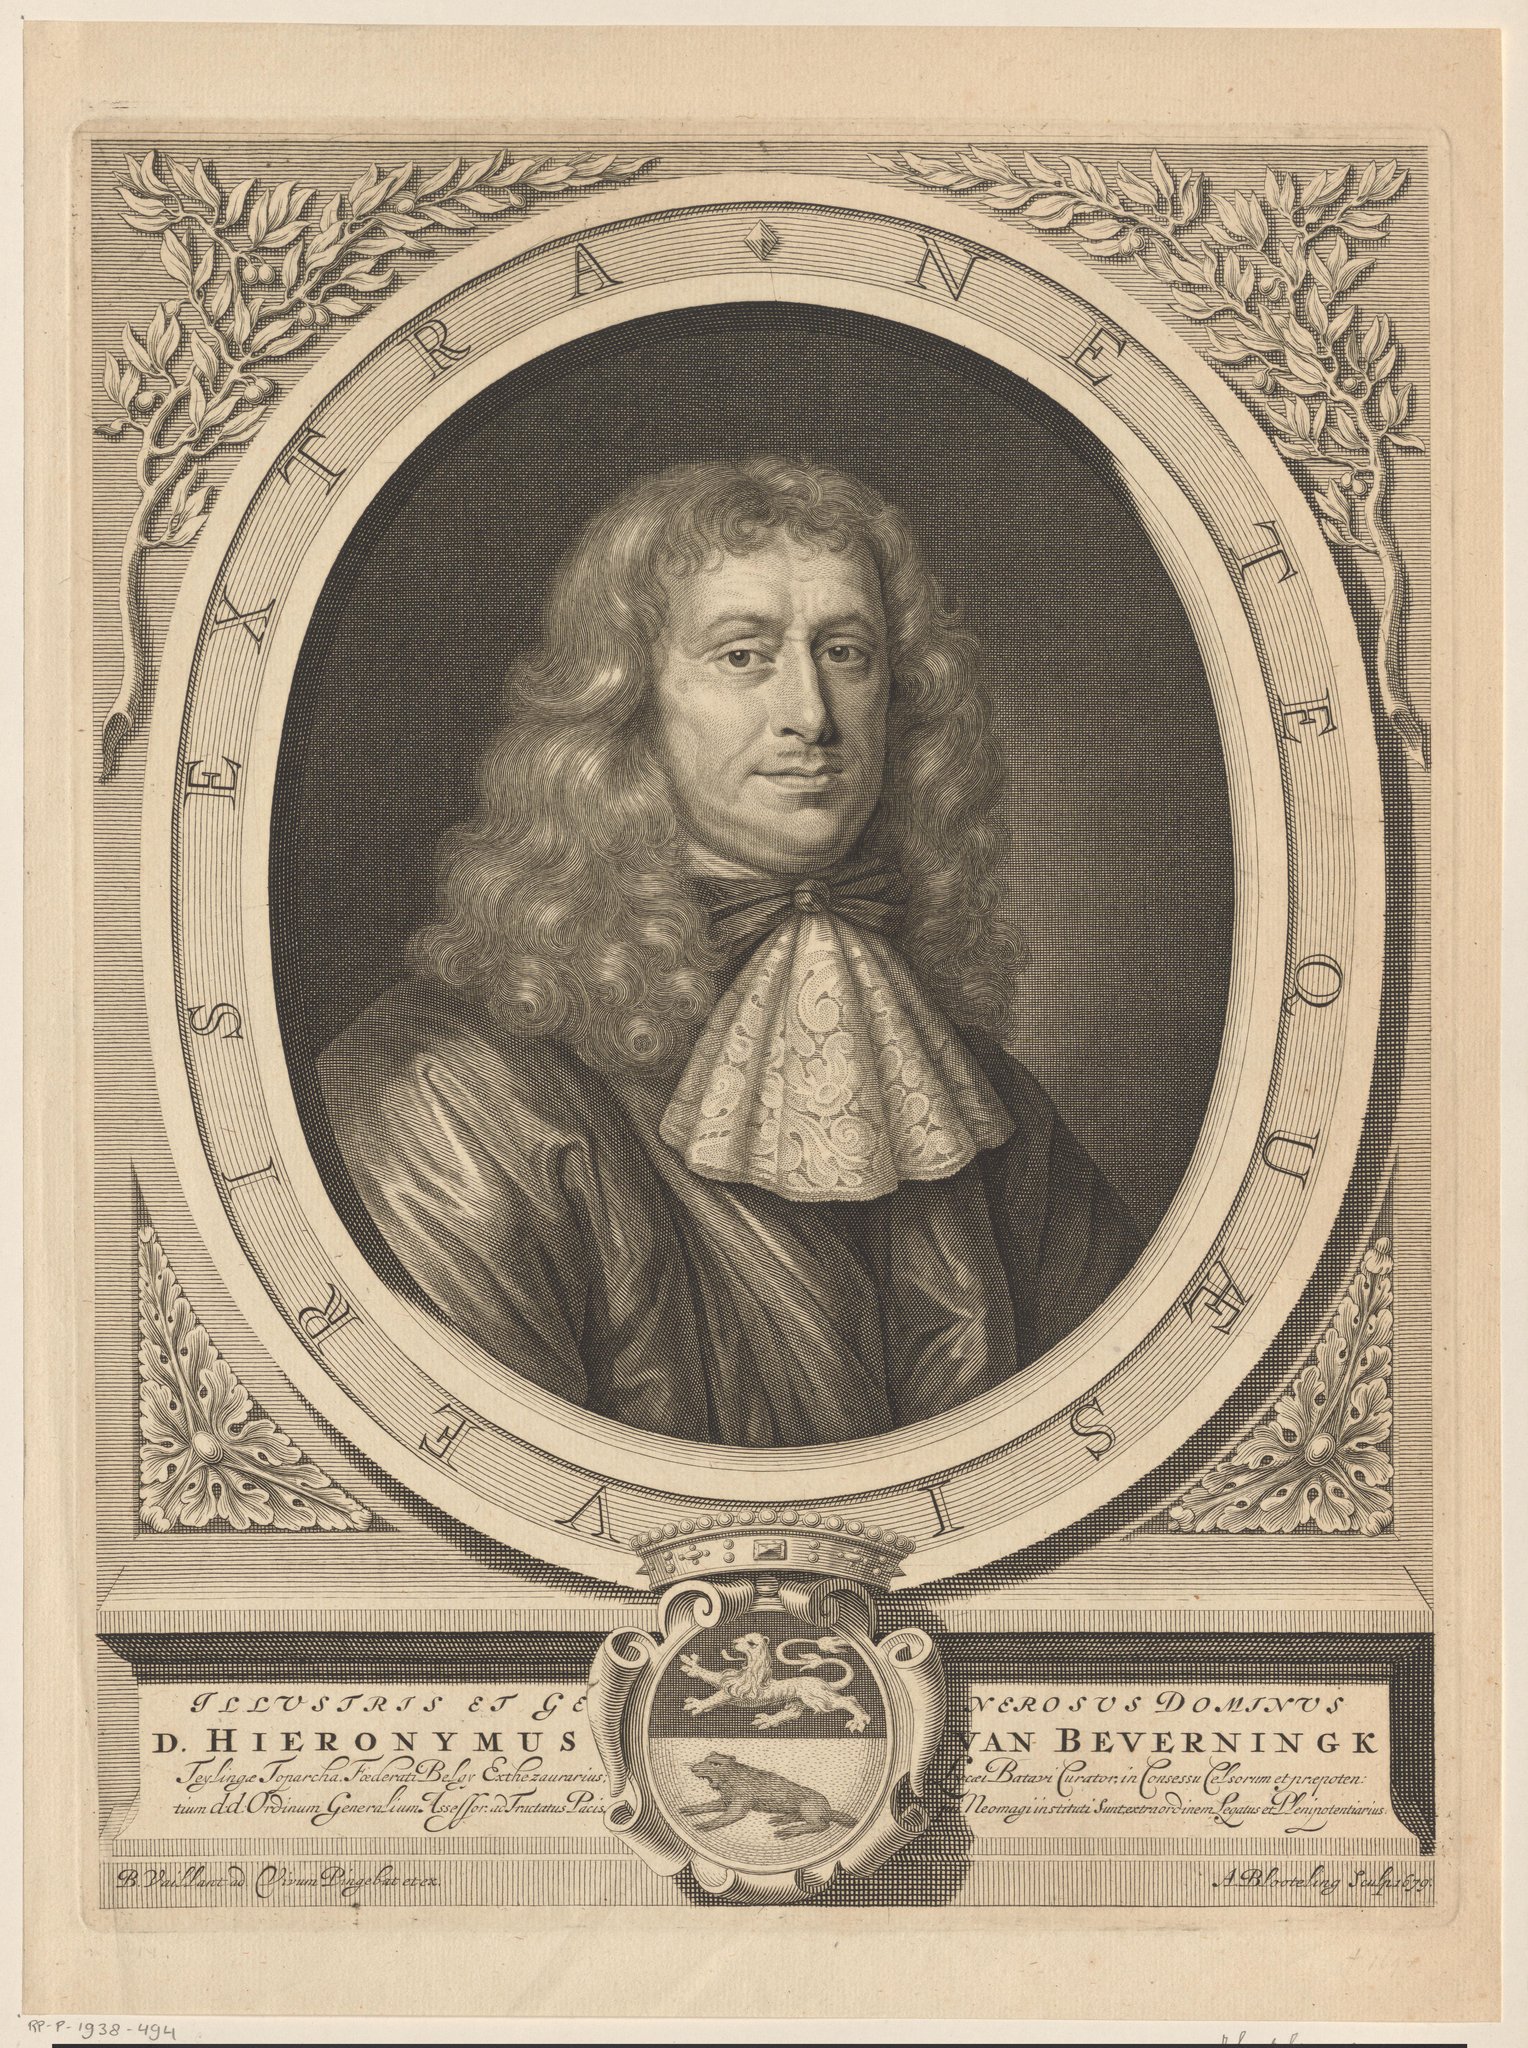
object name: print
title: Portret van Hieronymus van Beverningk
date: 1679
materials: paper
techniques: engraving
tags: gouda, leiden, historical persons, armorial bearing, heraldry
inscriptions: date